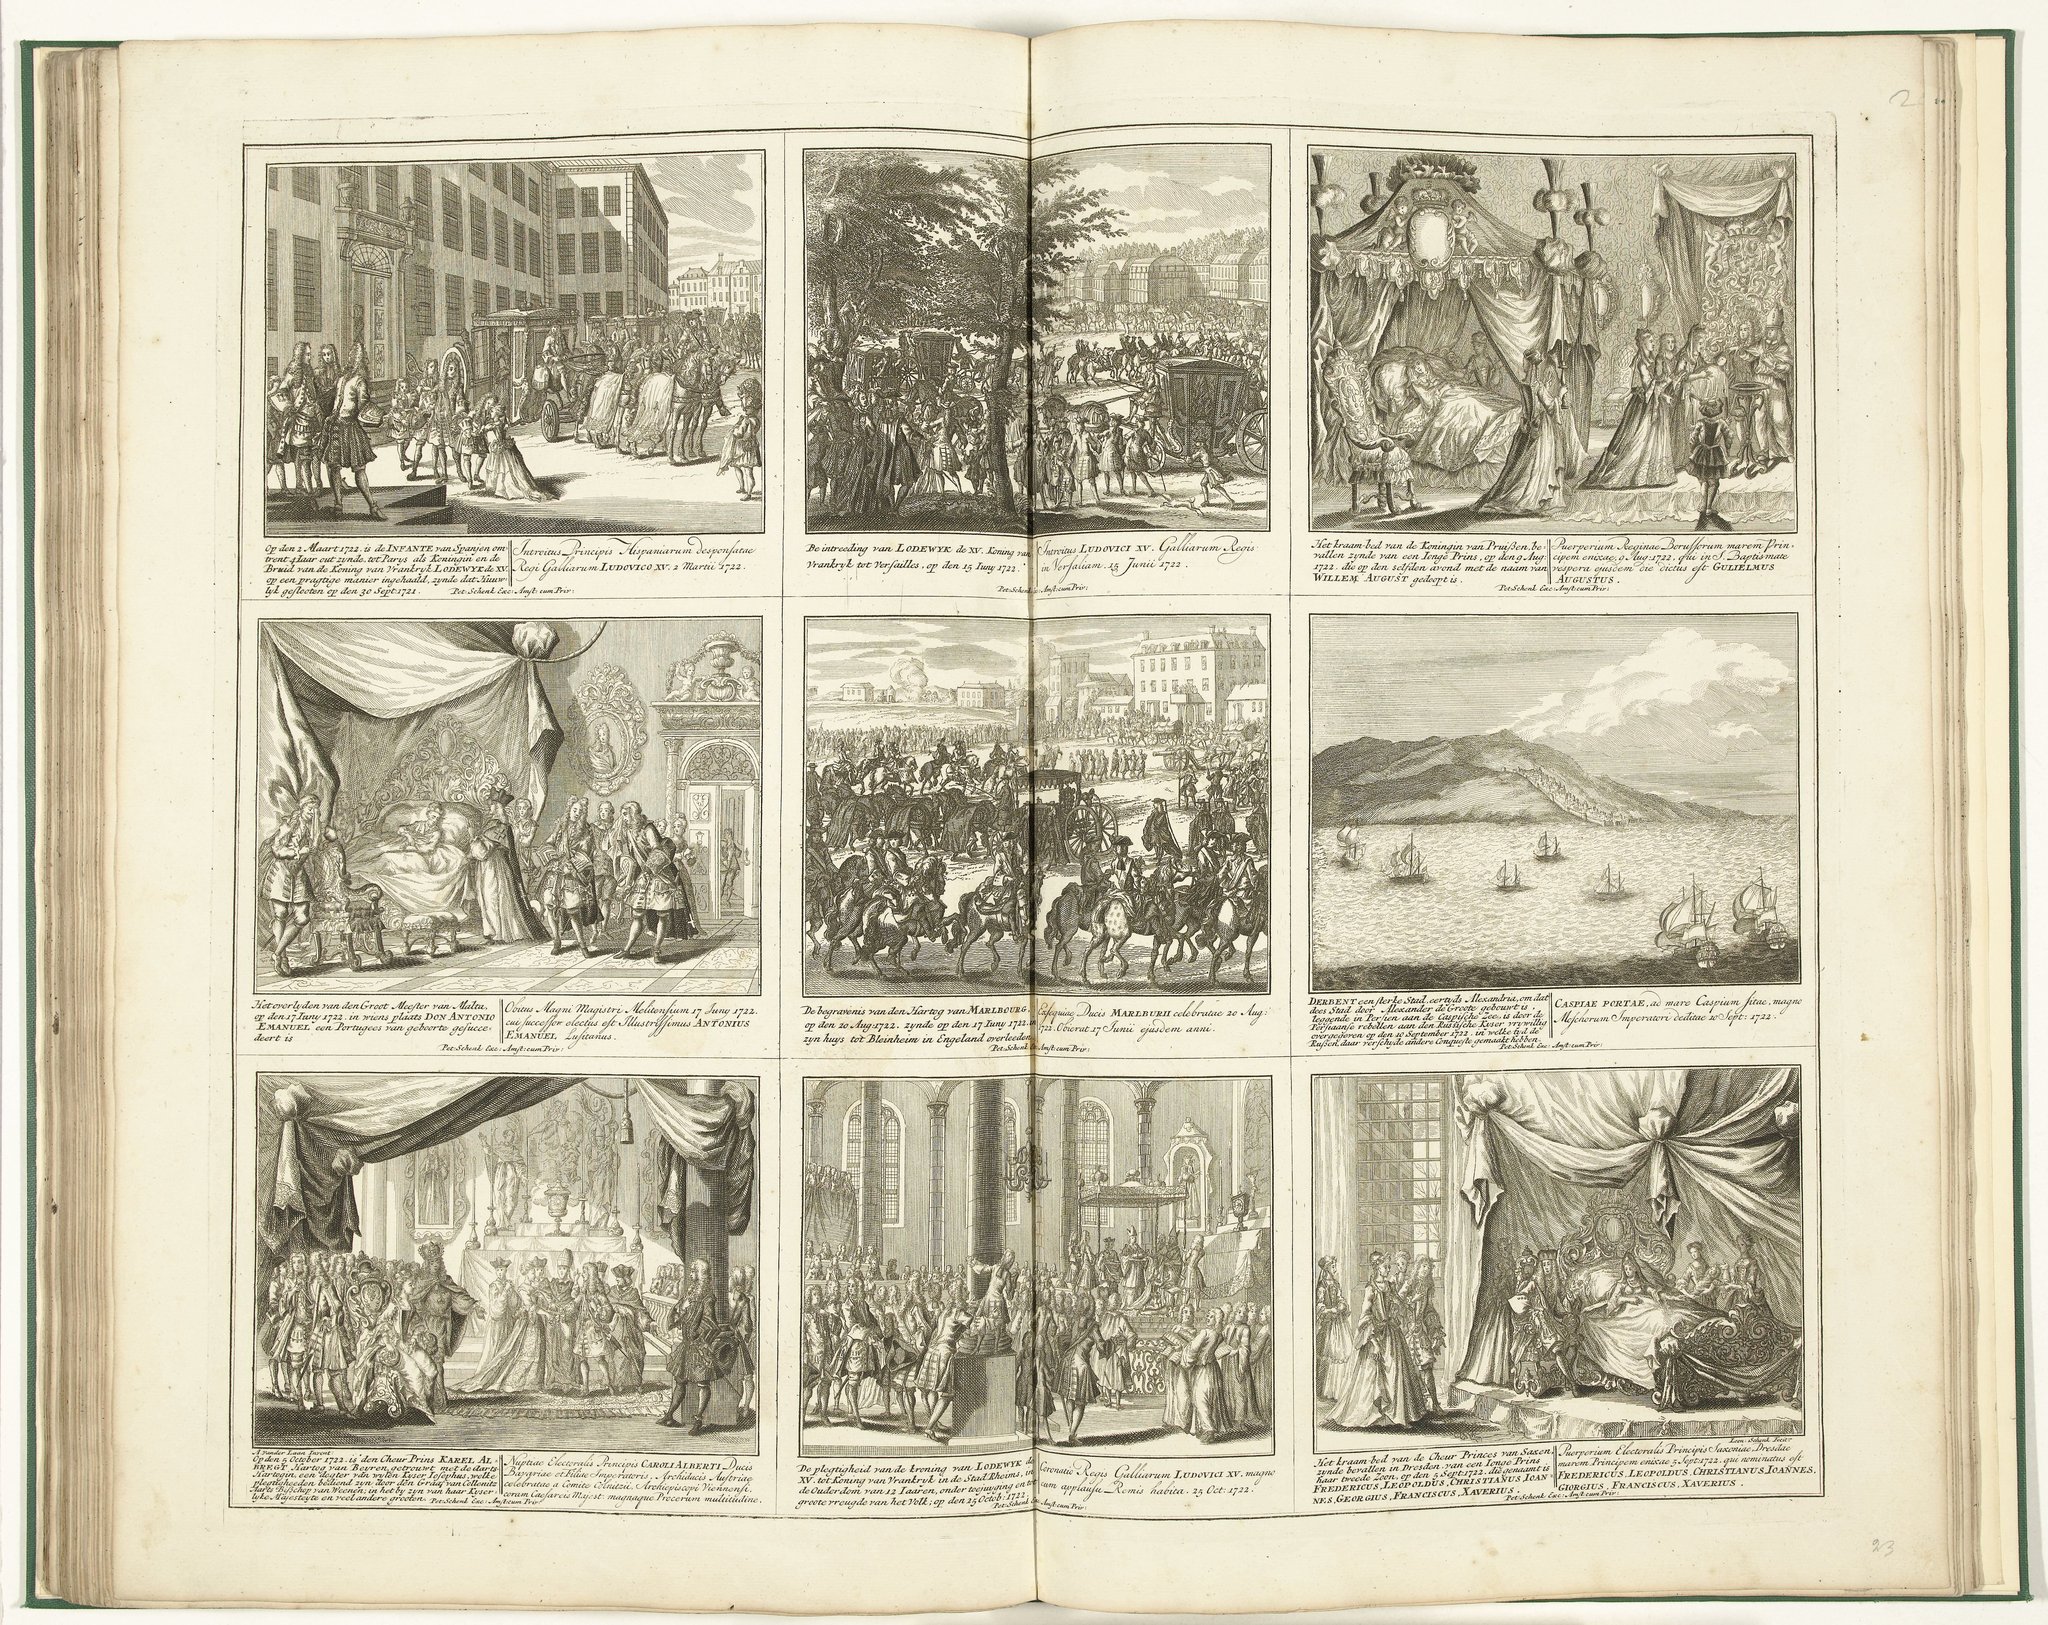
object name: print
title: Schouwburg van den oorlog (blad XXIII), 1722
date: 1722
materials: paper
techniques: etching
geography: amsterdam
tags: louis xv of france, deathbed, coronation of a ruler, (civil) marriage ceremonies, confinement, birth, paris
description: Blad met negen voorstellingen van gebeurtenissen uit het jaar 1722. Blad XXIII in: Schouwburg van den oorlog (editie van 1720), het prentwerk met de gebundelde reeks van 31 platen over de Spaanse Successieoorlog.